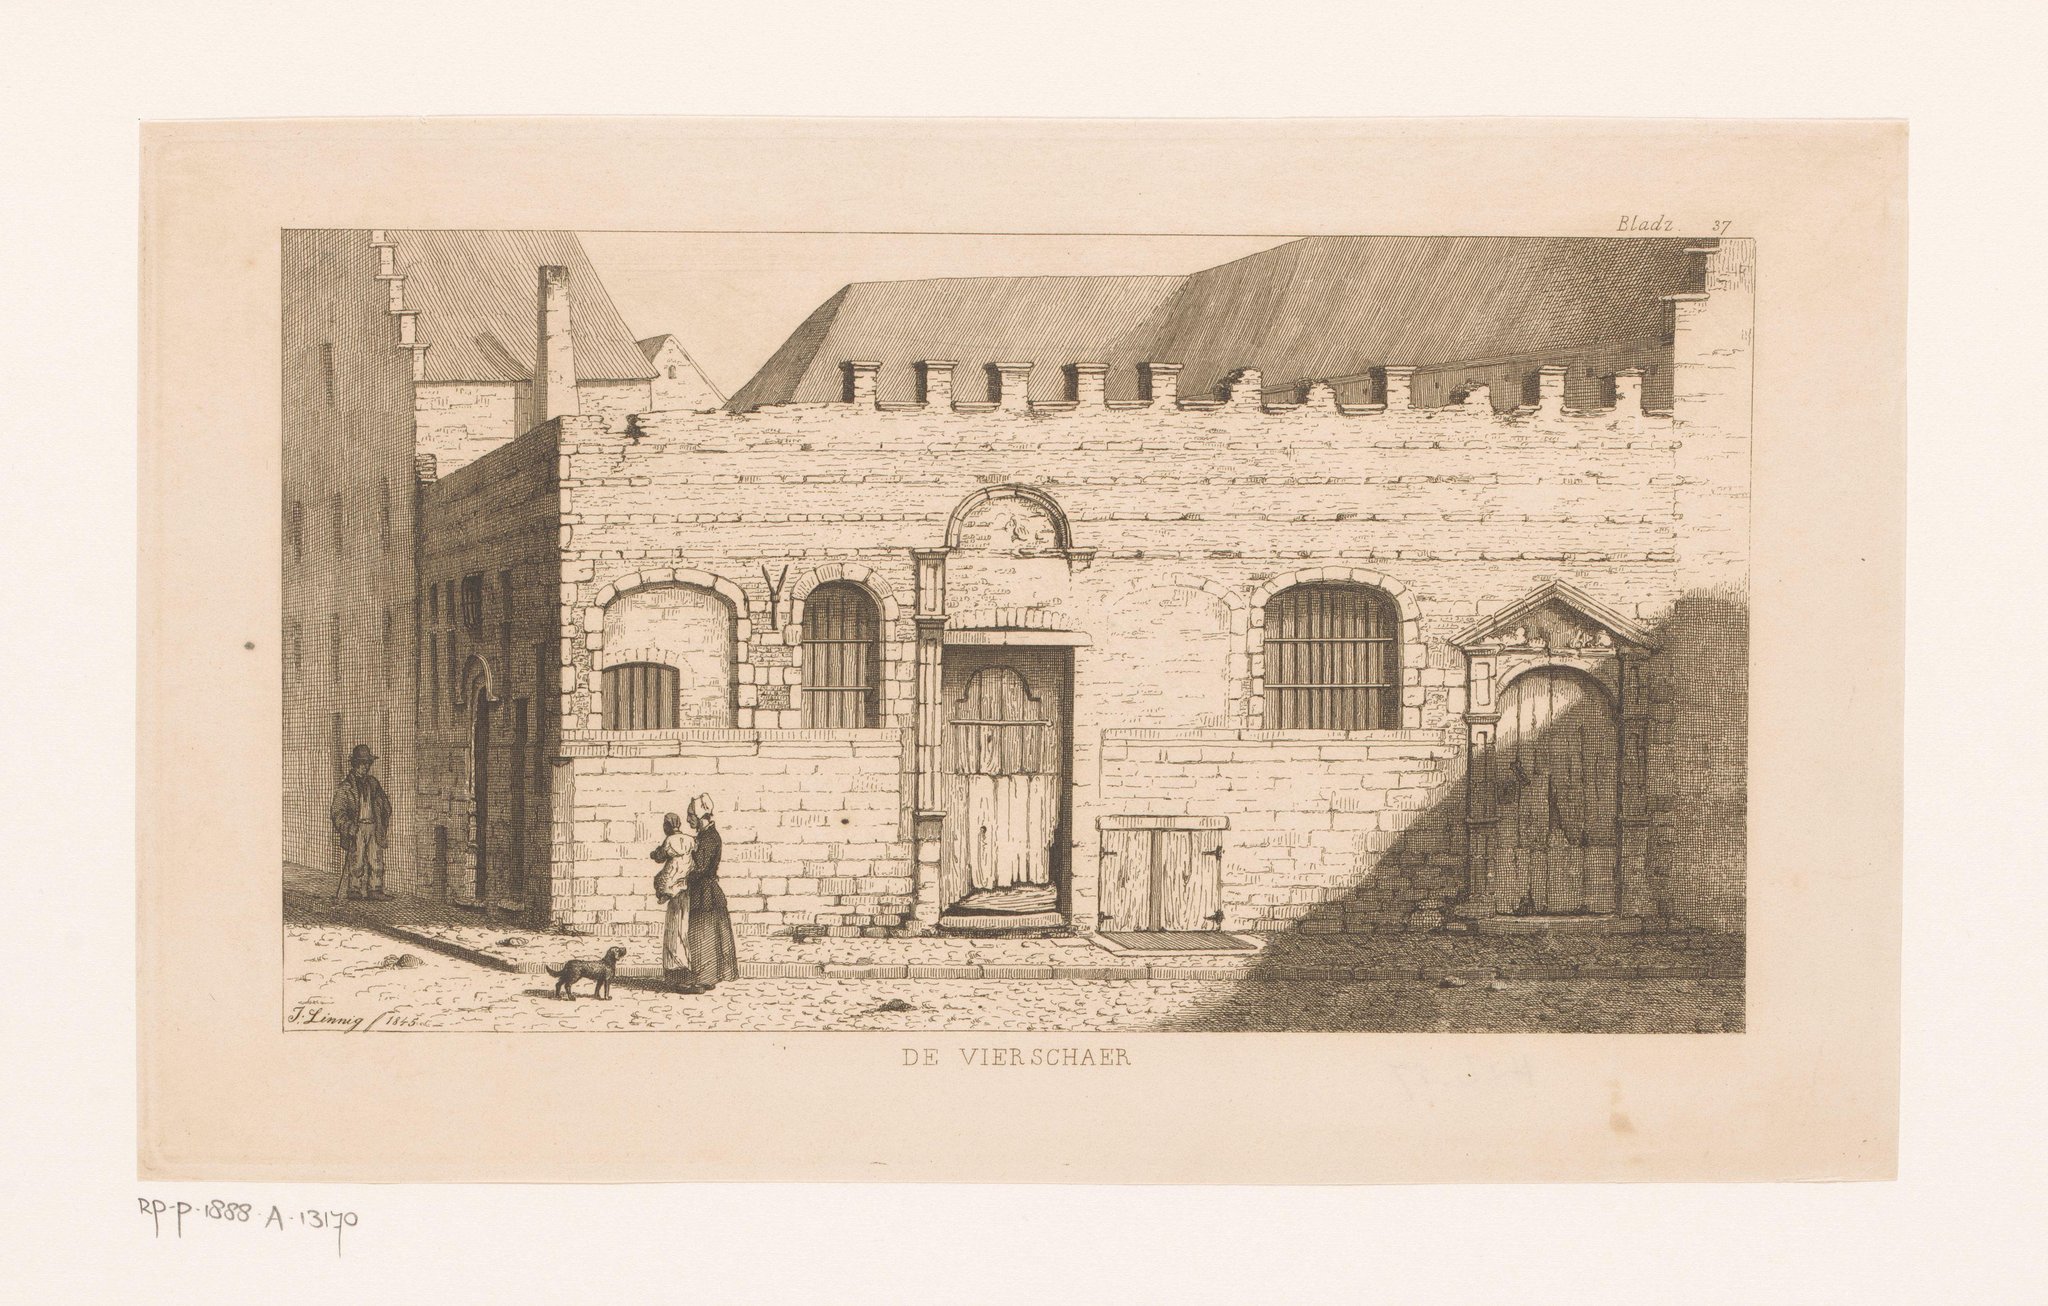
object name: book illustration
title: Vierschaar van Antwerpen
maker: jean théodore joseph linnig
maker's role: draughtsman, print maker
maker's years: 1815-1891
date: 1845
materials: paper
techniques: etching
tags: court building, antwerp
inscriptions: collector's mark: Lugt 2228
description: Prent uit: Mertens, F.H. en K.L. Torfs. Geschiedenis van Antwerpen. 5 dln. Antwerpen: J.P. van Dieren, 1845-1853, dl. 2, p. 37.